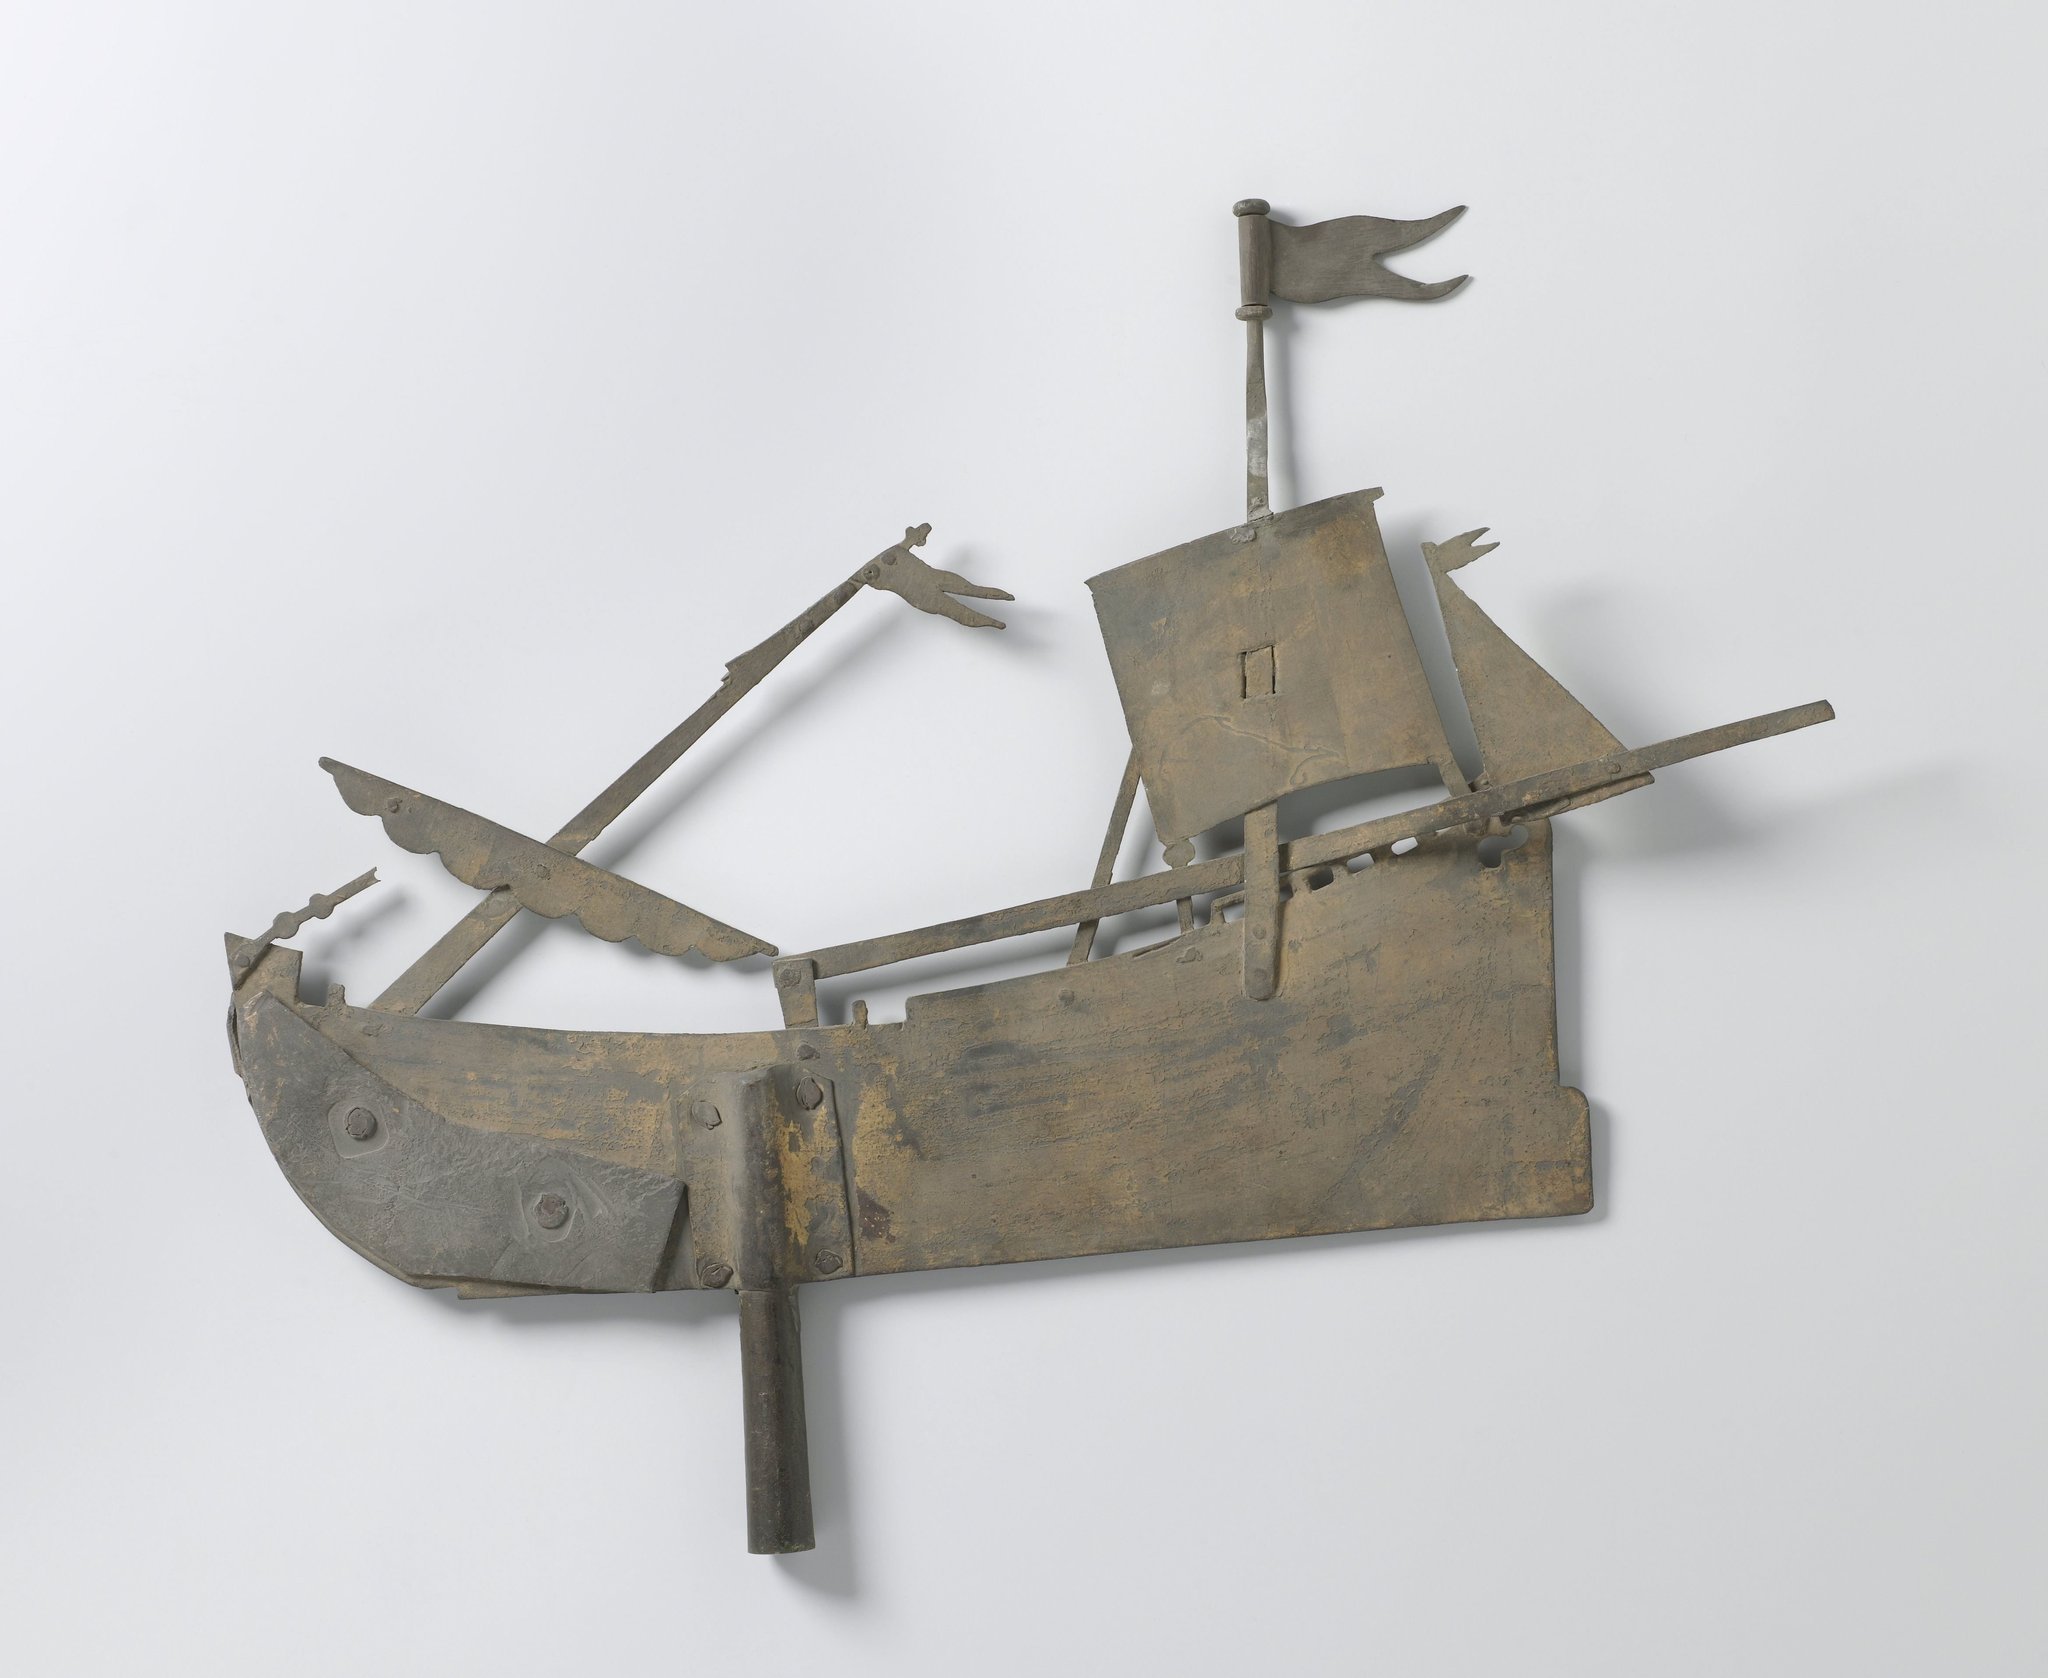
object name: weather vane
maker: Anonymous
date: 1400-1950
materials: iron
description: Een windwijzer in de vorm van een haringbuis met gestreken grote mast. De fokkemast is schuin geplaatst.